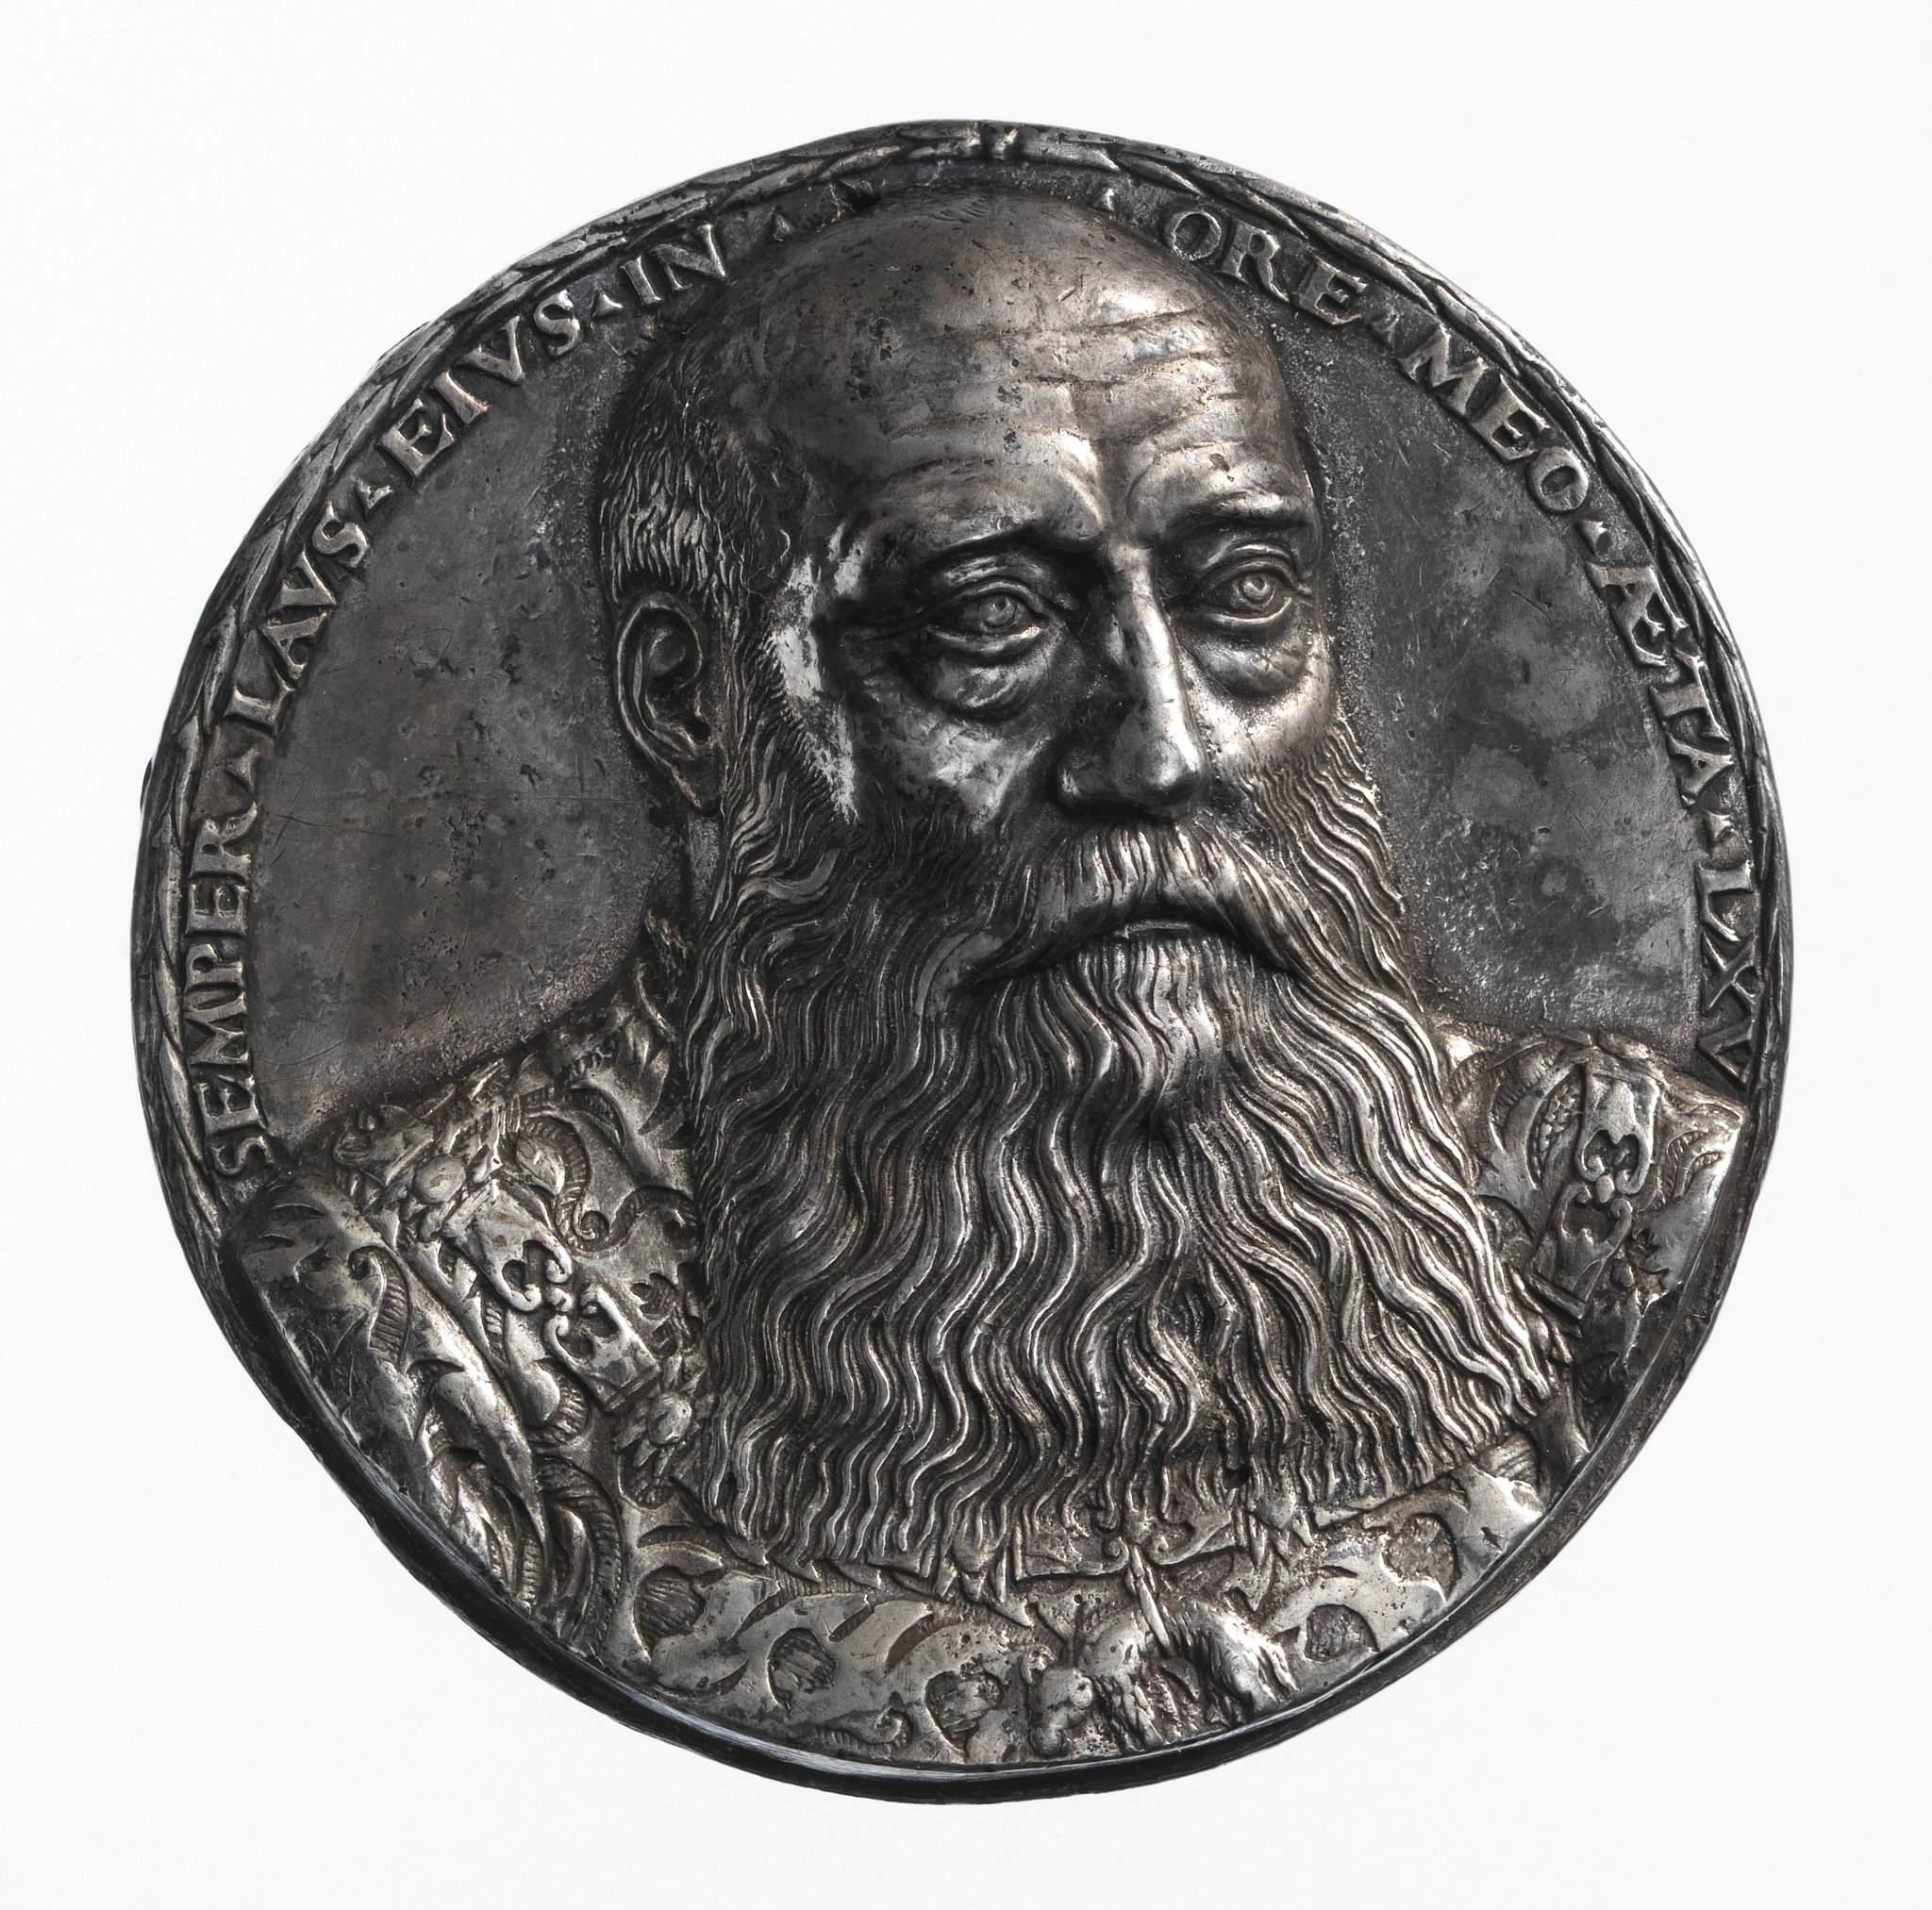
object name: medal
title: Portrait medal of George the Bearded (duke of Saxony) (obverse); coat of arms (reverse)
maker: peter flötner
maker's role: artist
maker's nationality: german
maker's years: 1485-1546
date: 1537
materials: silver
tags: men,portraits,coat of arms